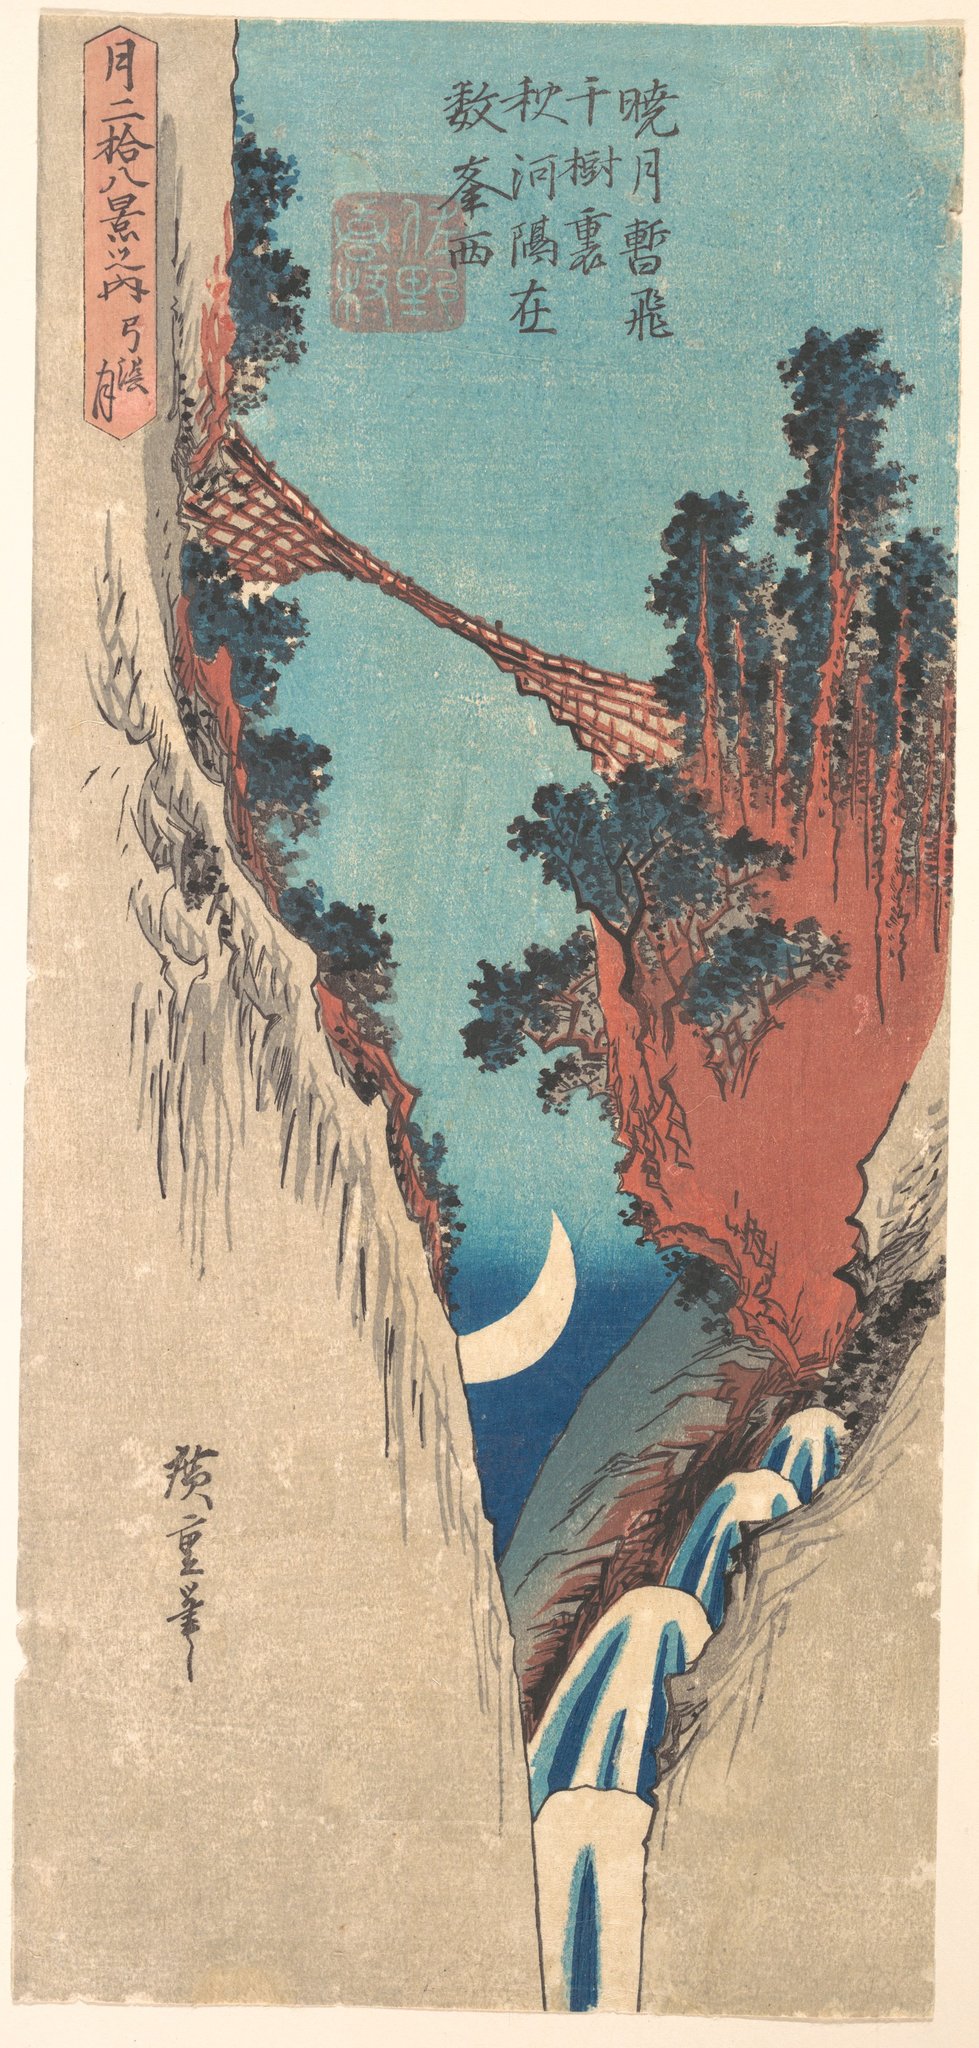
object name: print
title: Bow Moon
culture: japanese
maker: utagawa hiroshige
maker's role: artist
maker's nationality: japanese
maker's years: 1797-1858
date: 1797-1858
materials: ink, paper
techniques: woodblock print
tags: moon,mountains,trees